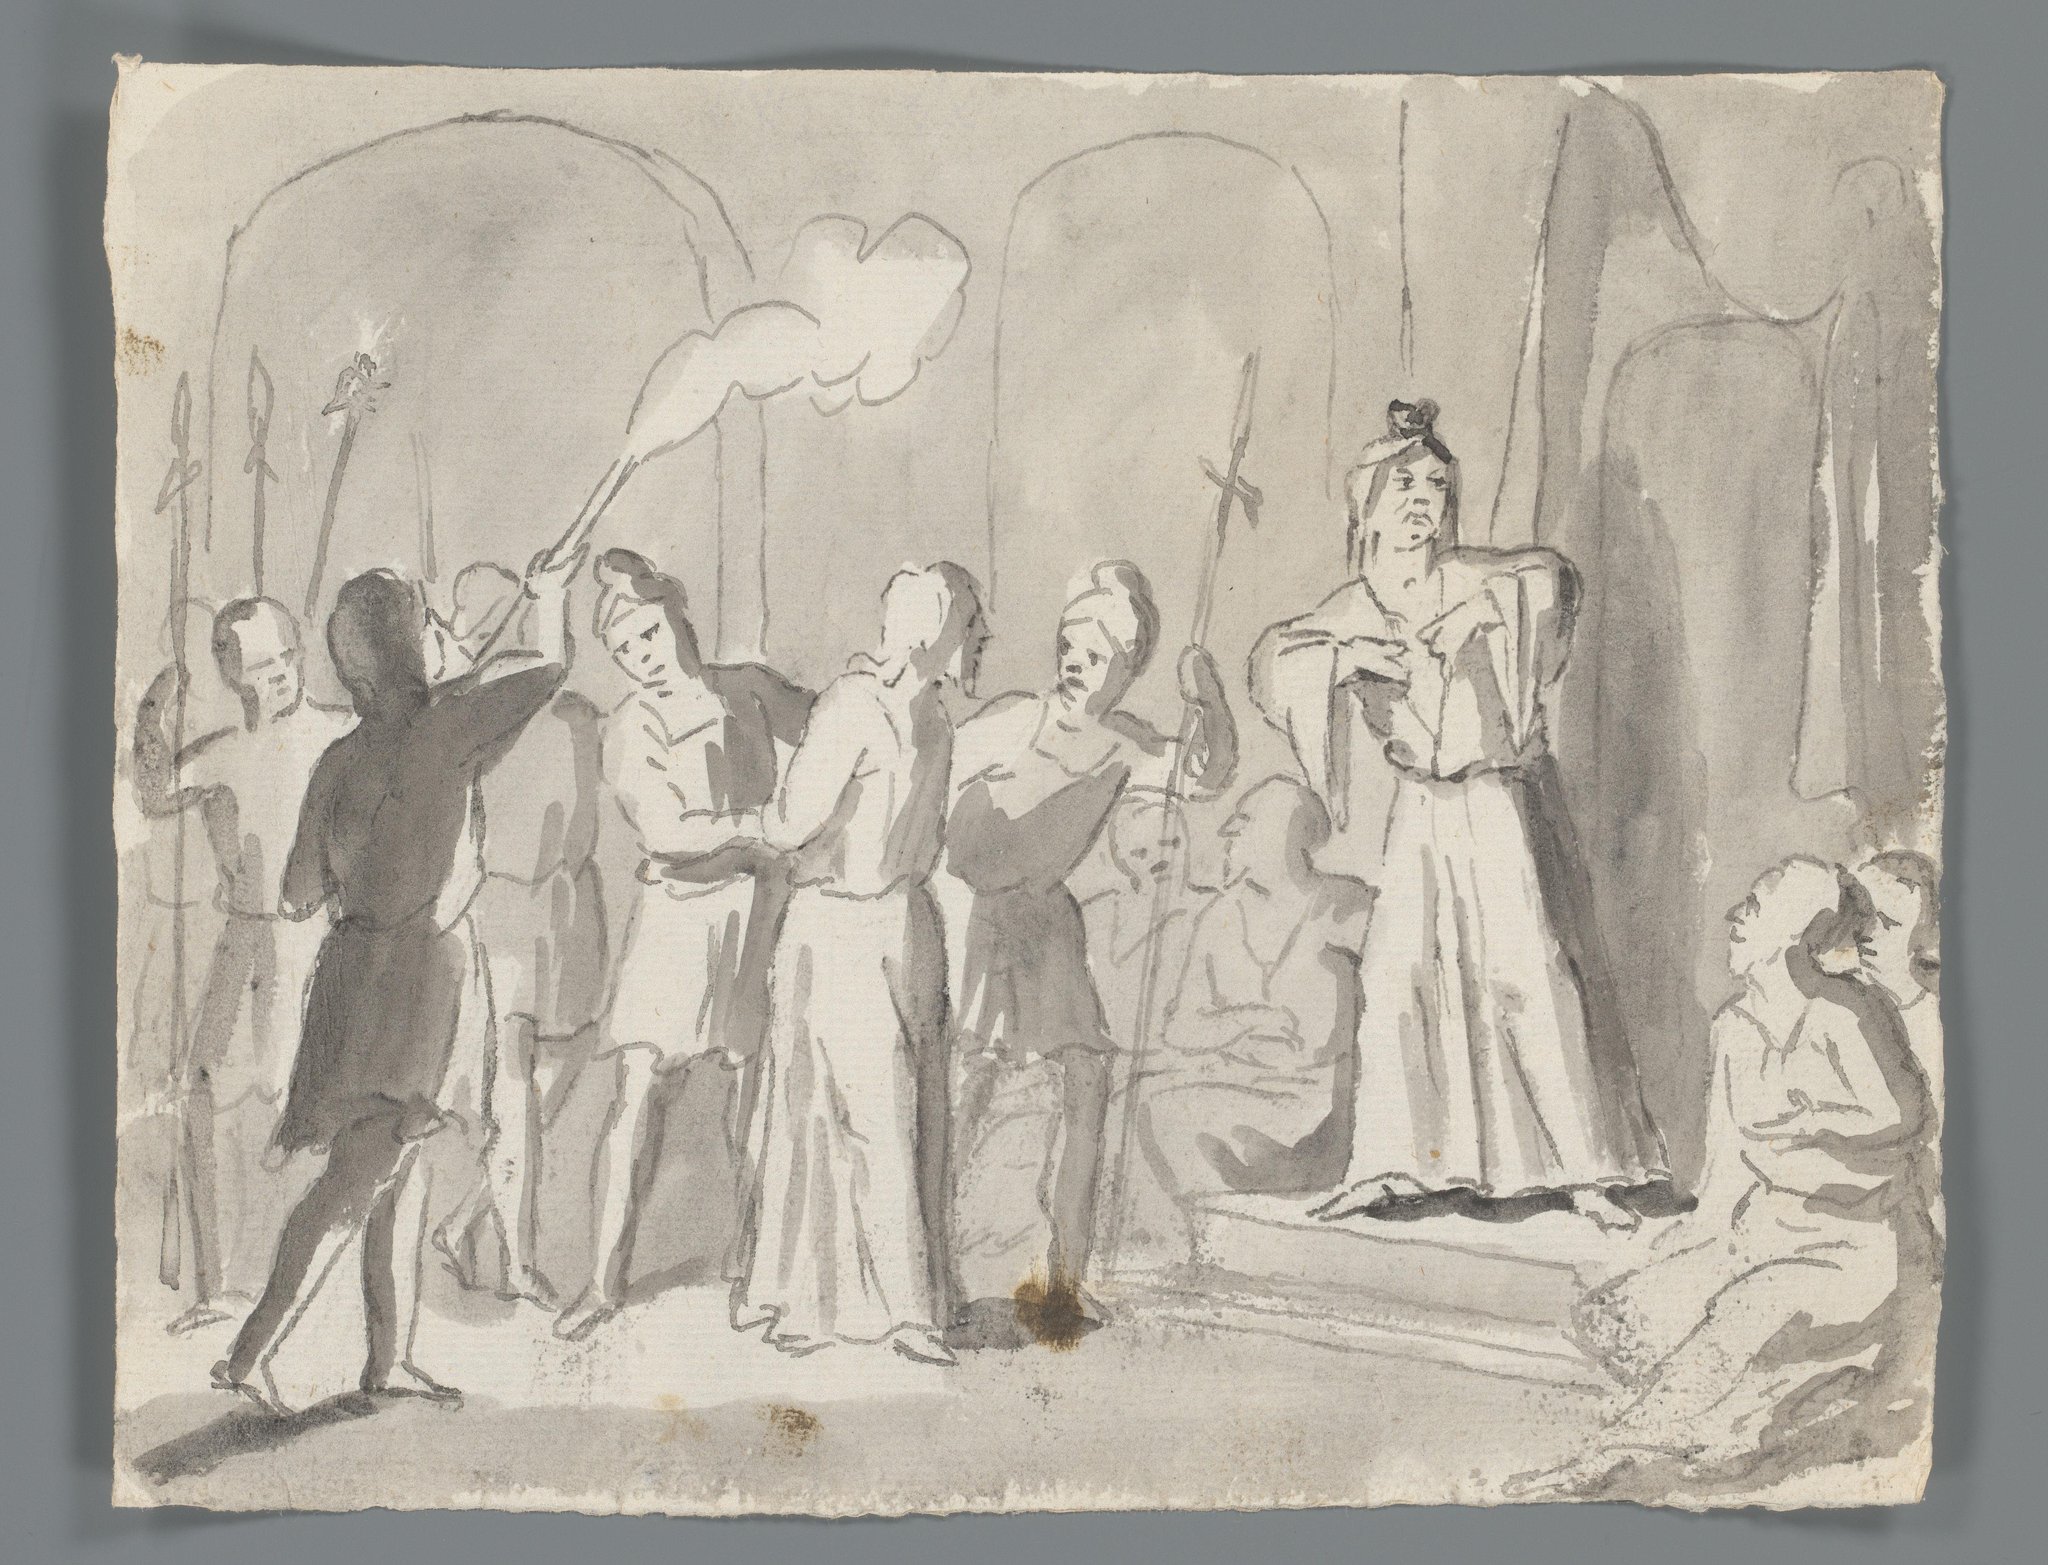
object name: drawing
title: Christus voor Kajafas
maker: matthijs balen (1684-1766)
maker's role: draughtsman, painter, print maker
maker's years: 1684-1766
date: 1694-1766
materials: paper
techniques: brush, pen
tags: caiaphas tearing his clothes ~ trial of christ